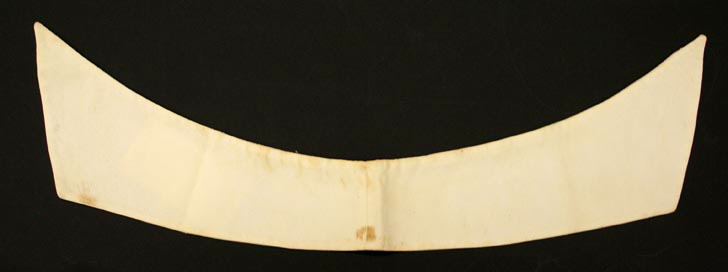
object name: collar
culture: american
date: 1700-1943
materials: cotton